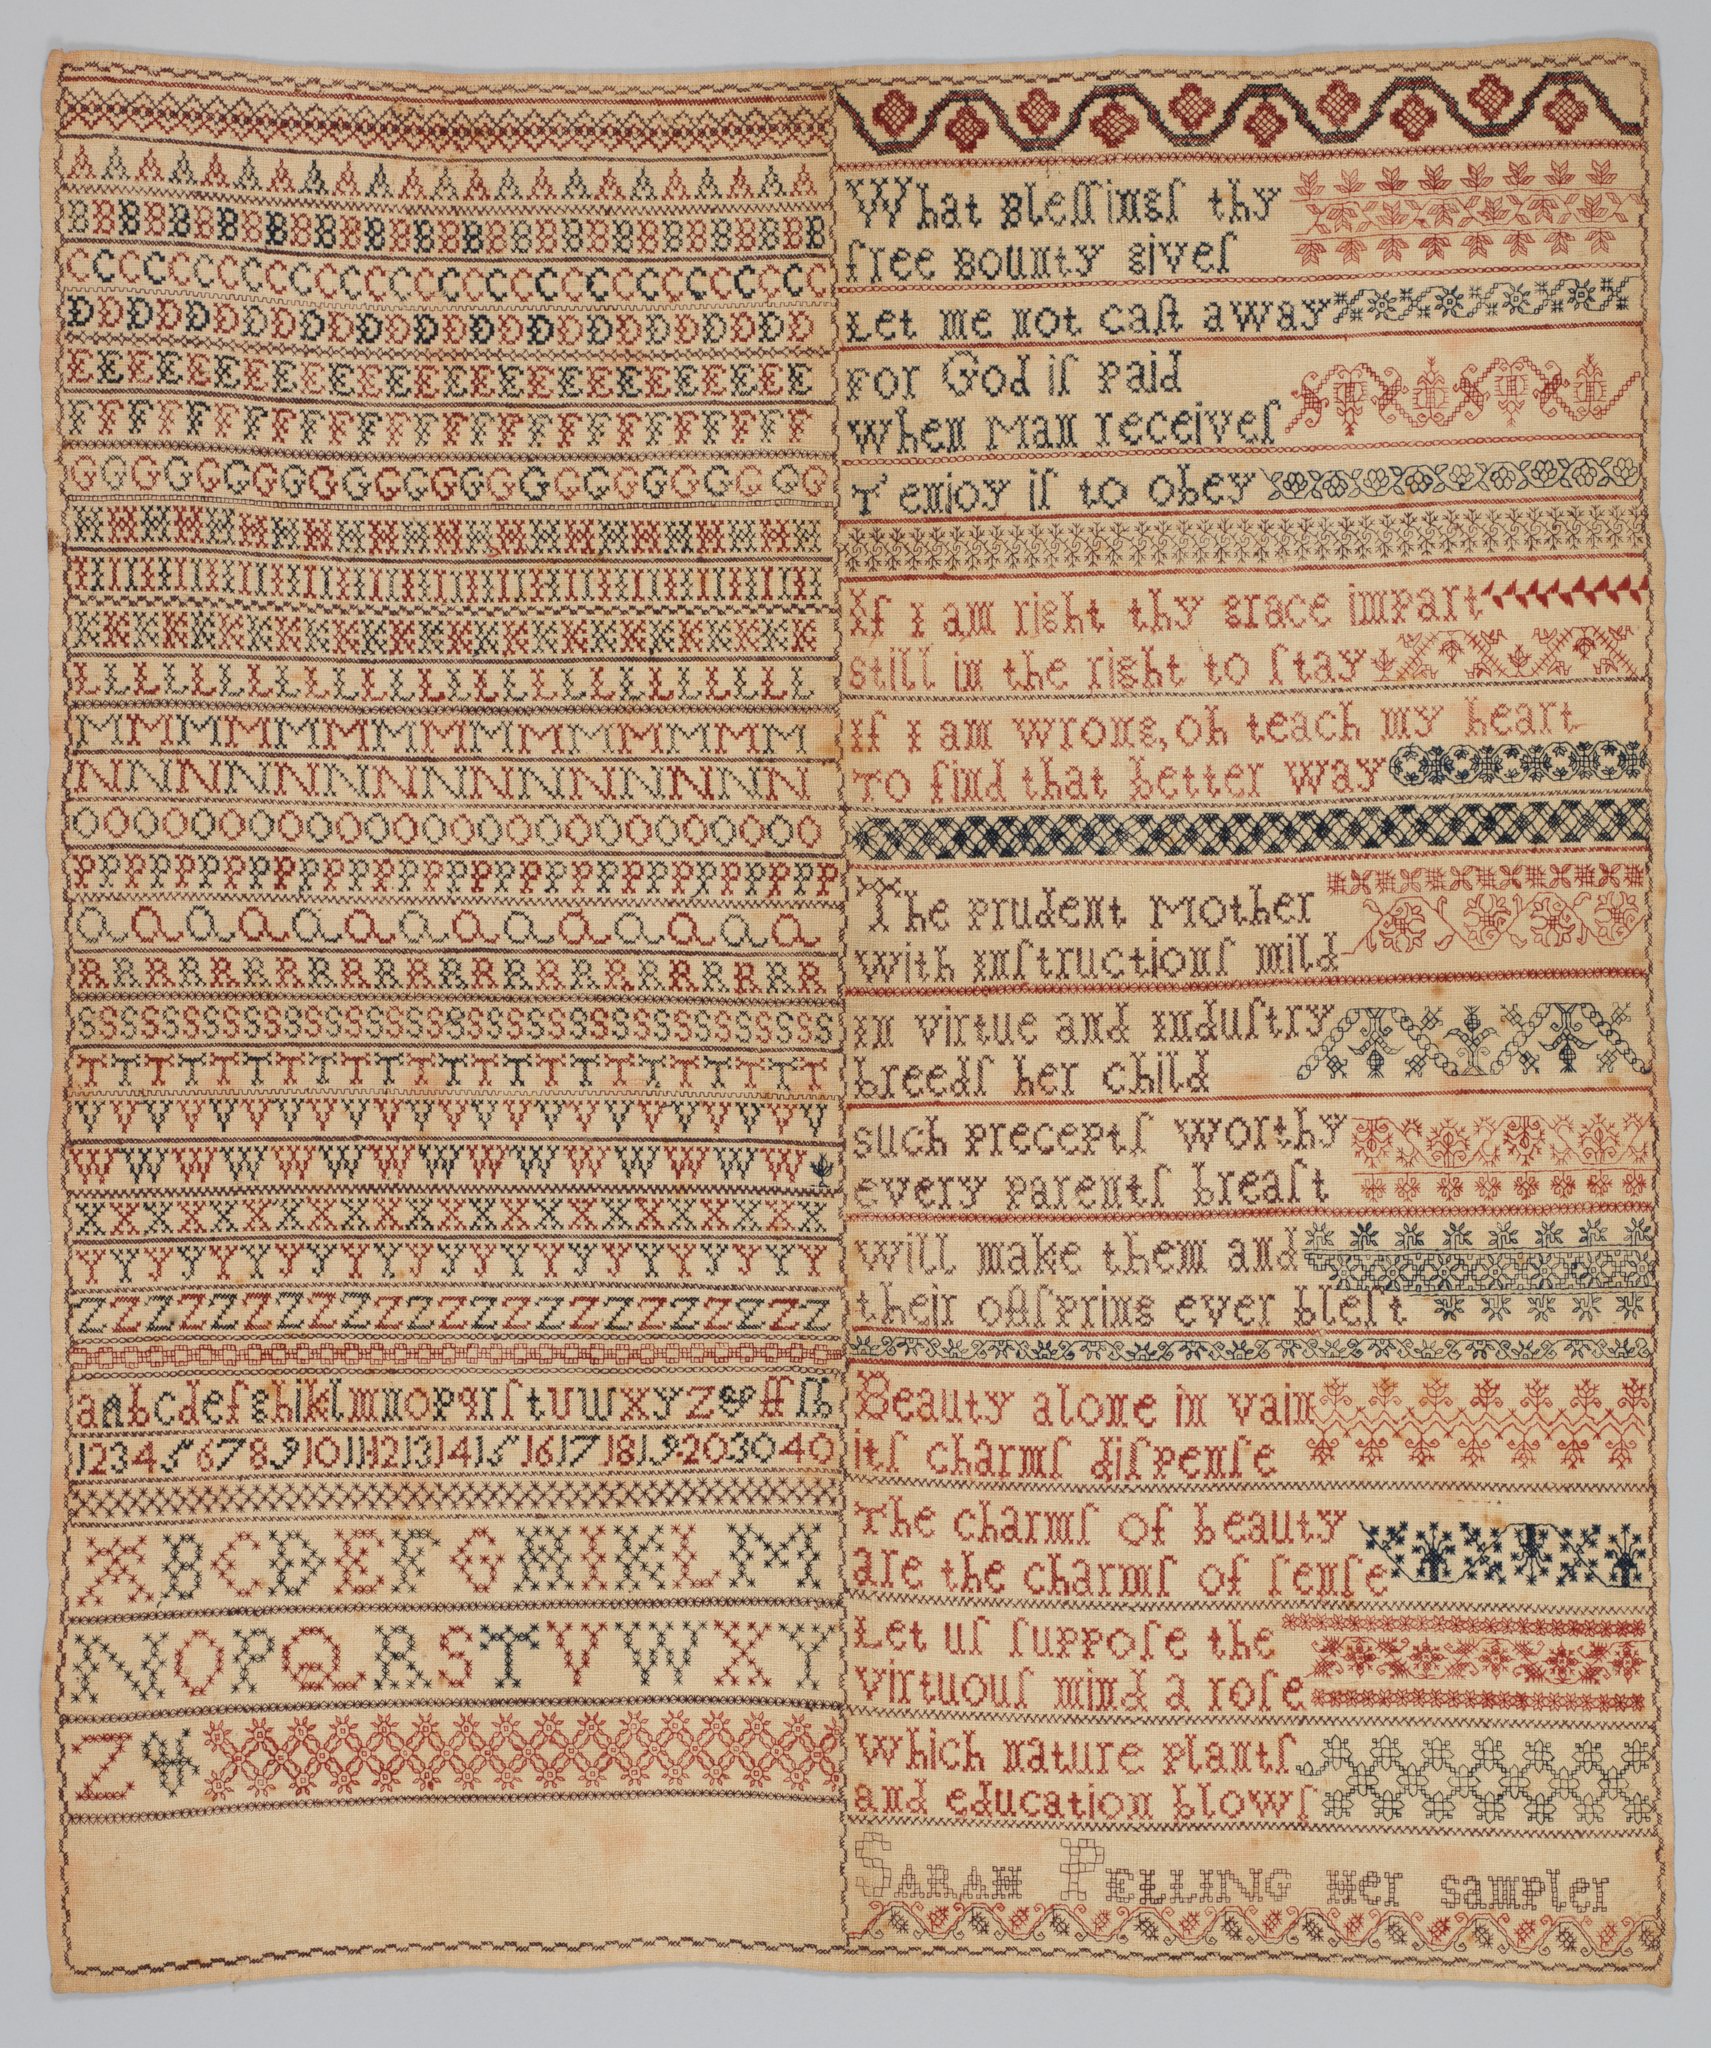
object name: sampler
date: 1701-1800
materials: cotton, linen